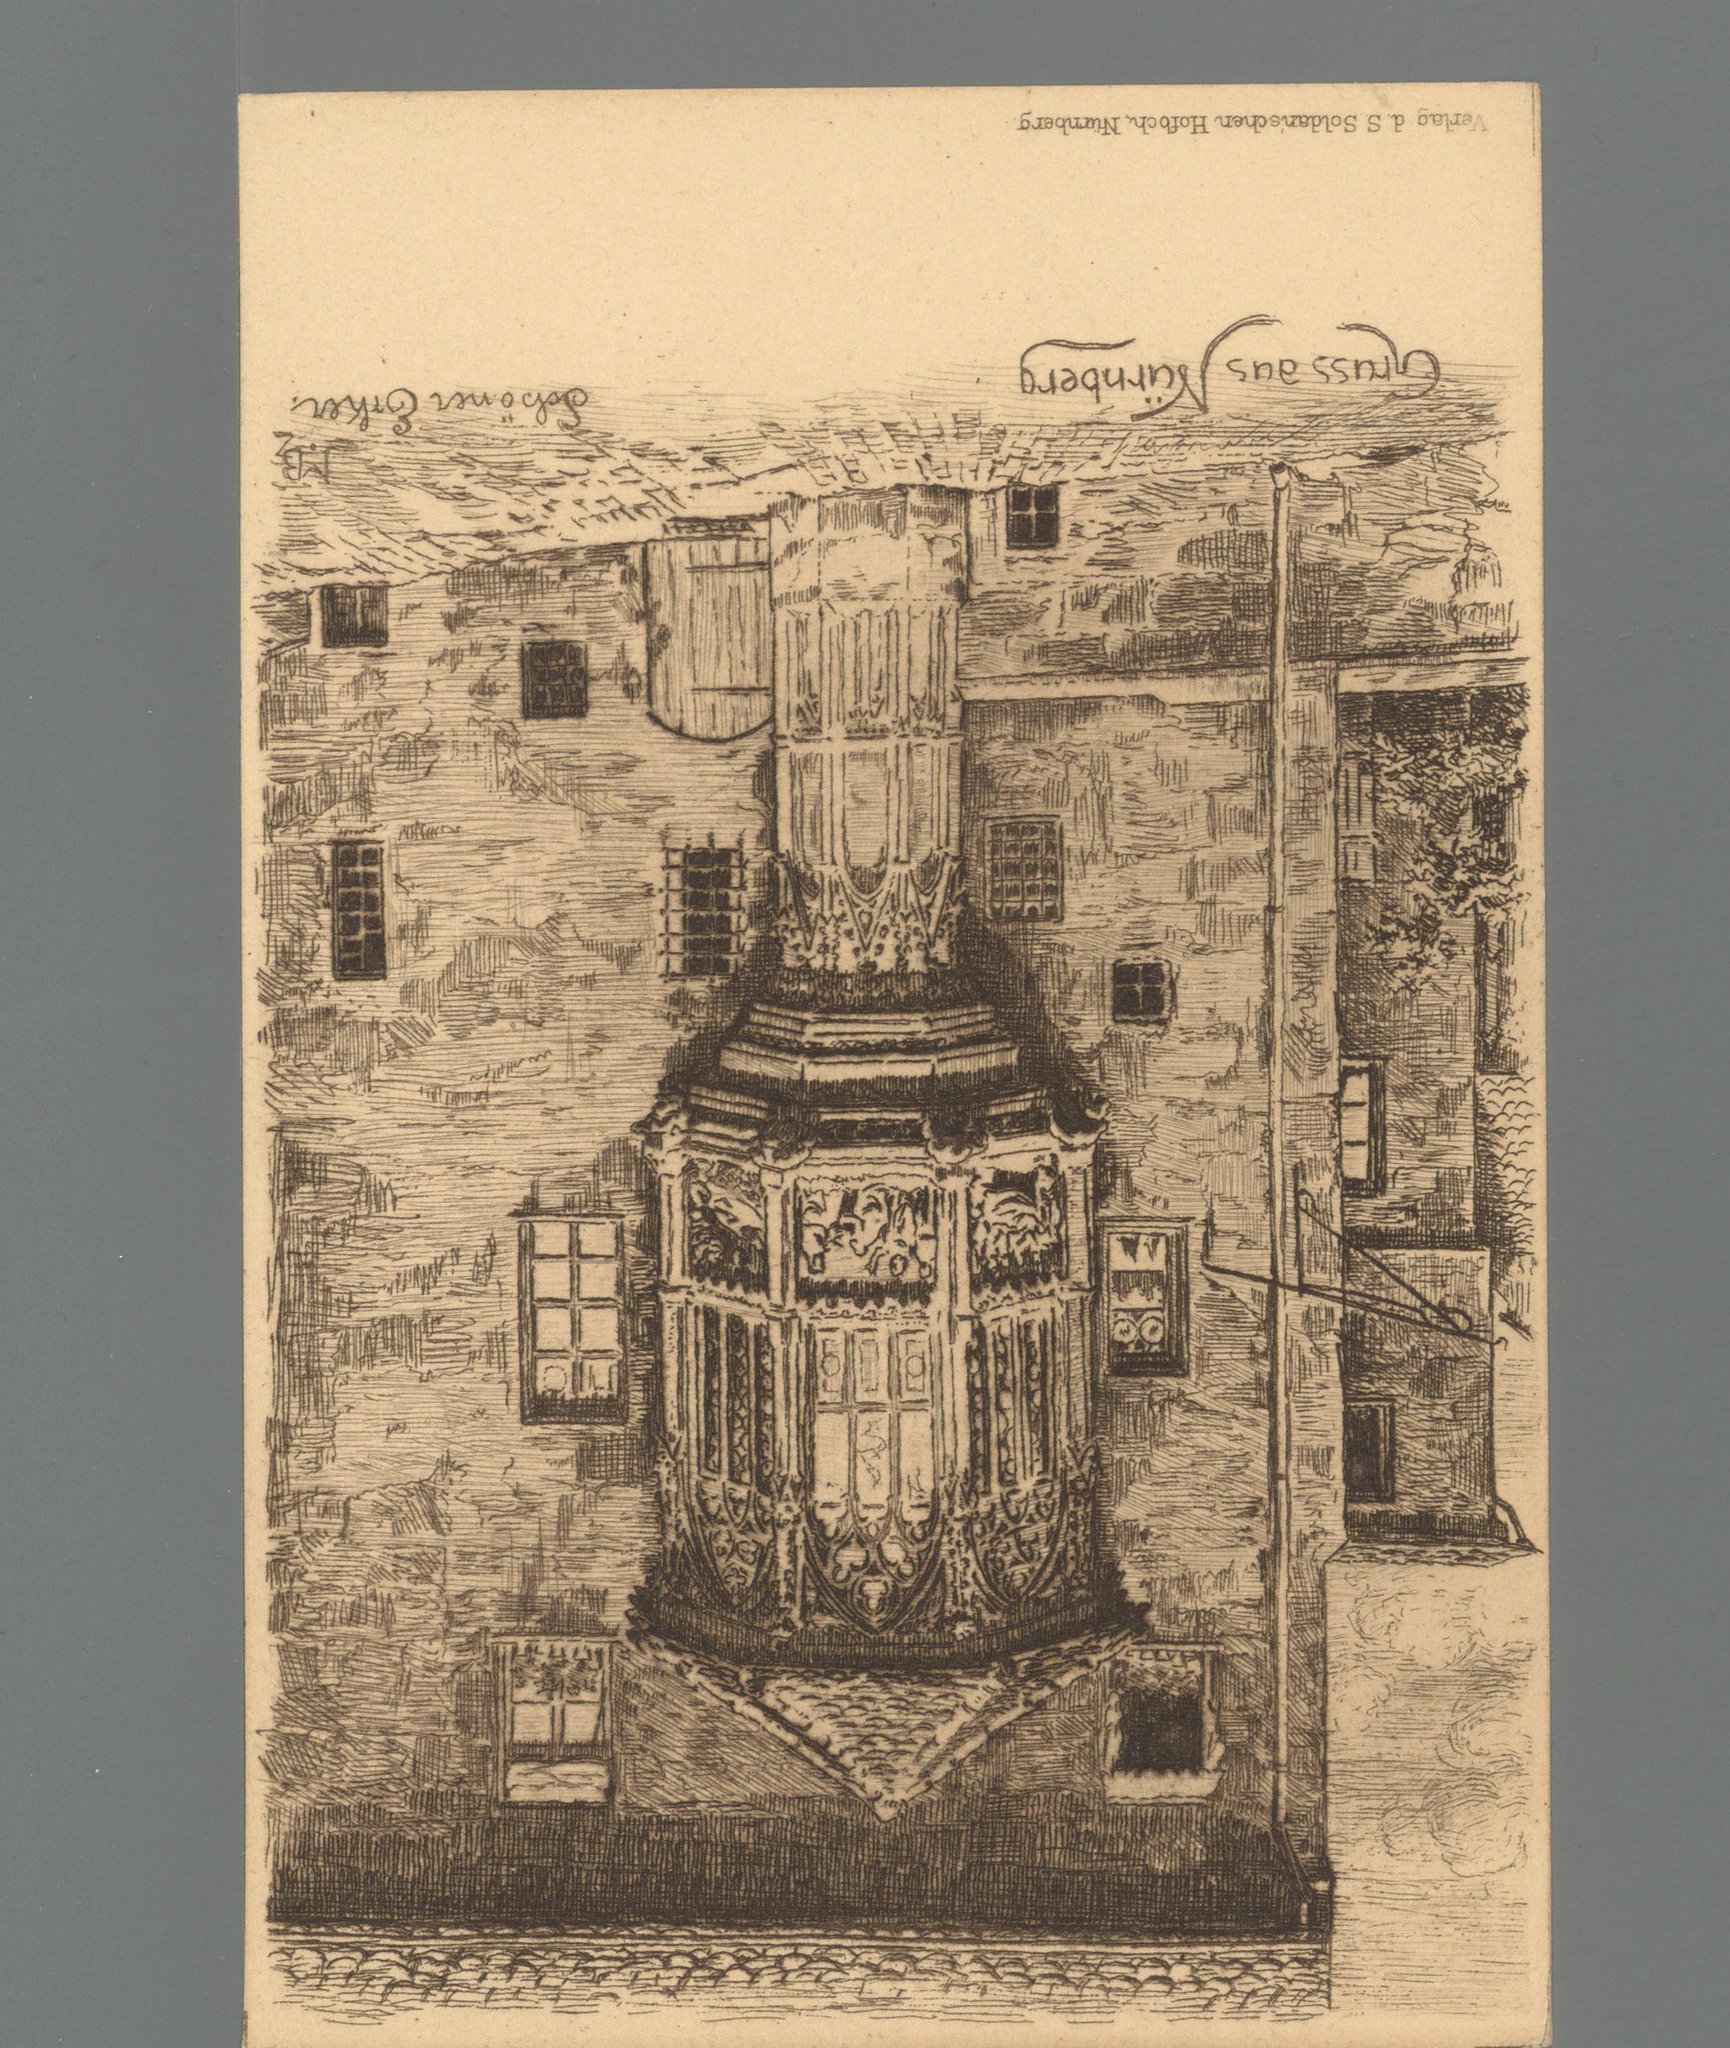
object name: ansichtkaart, prentbriefkaart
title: Gruss aus Nürnberg. Schöner Erker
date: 1905-1909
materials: cardboard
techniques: etching, writing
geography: nuremberg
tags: bay-window, oriel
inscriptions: inscription: ‘MBz’